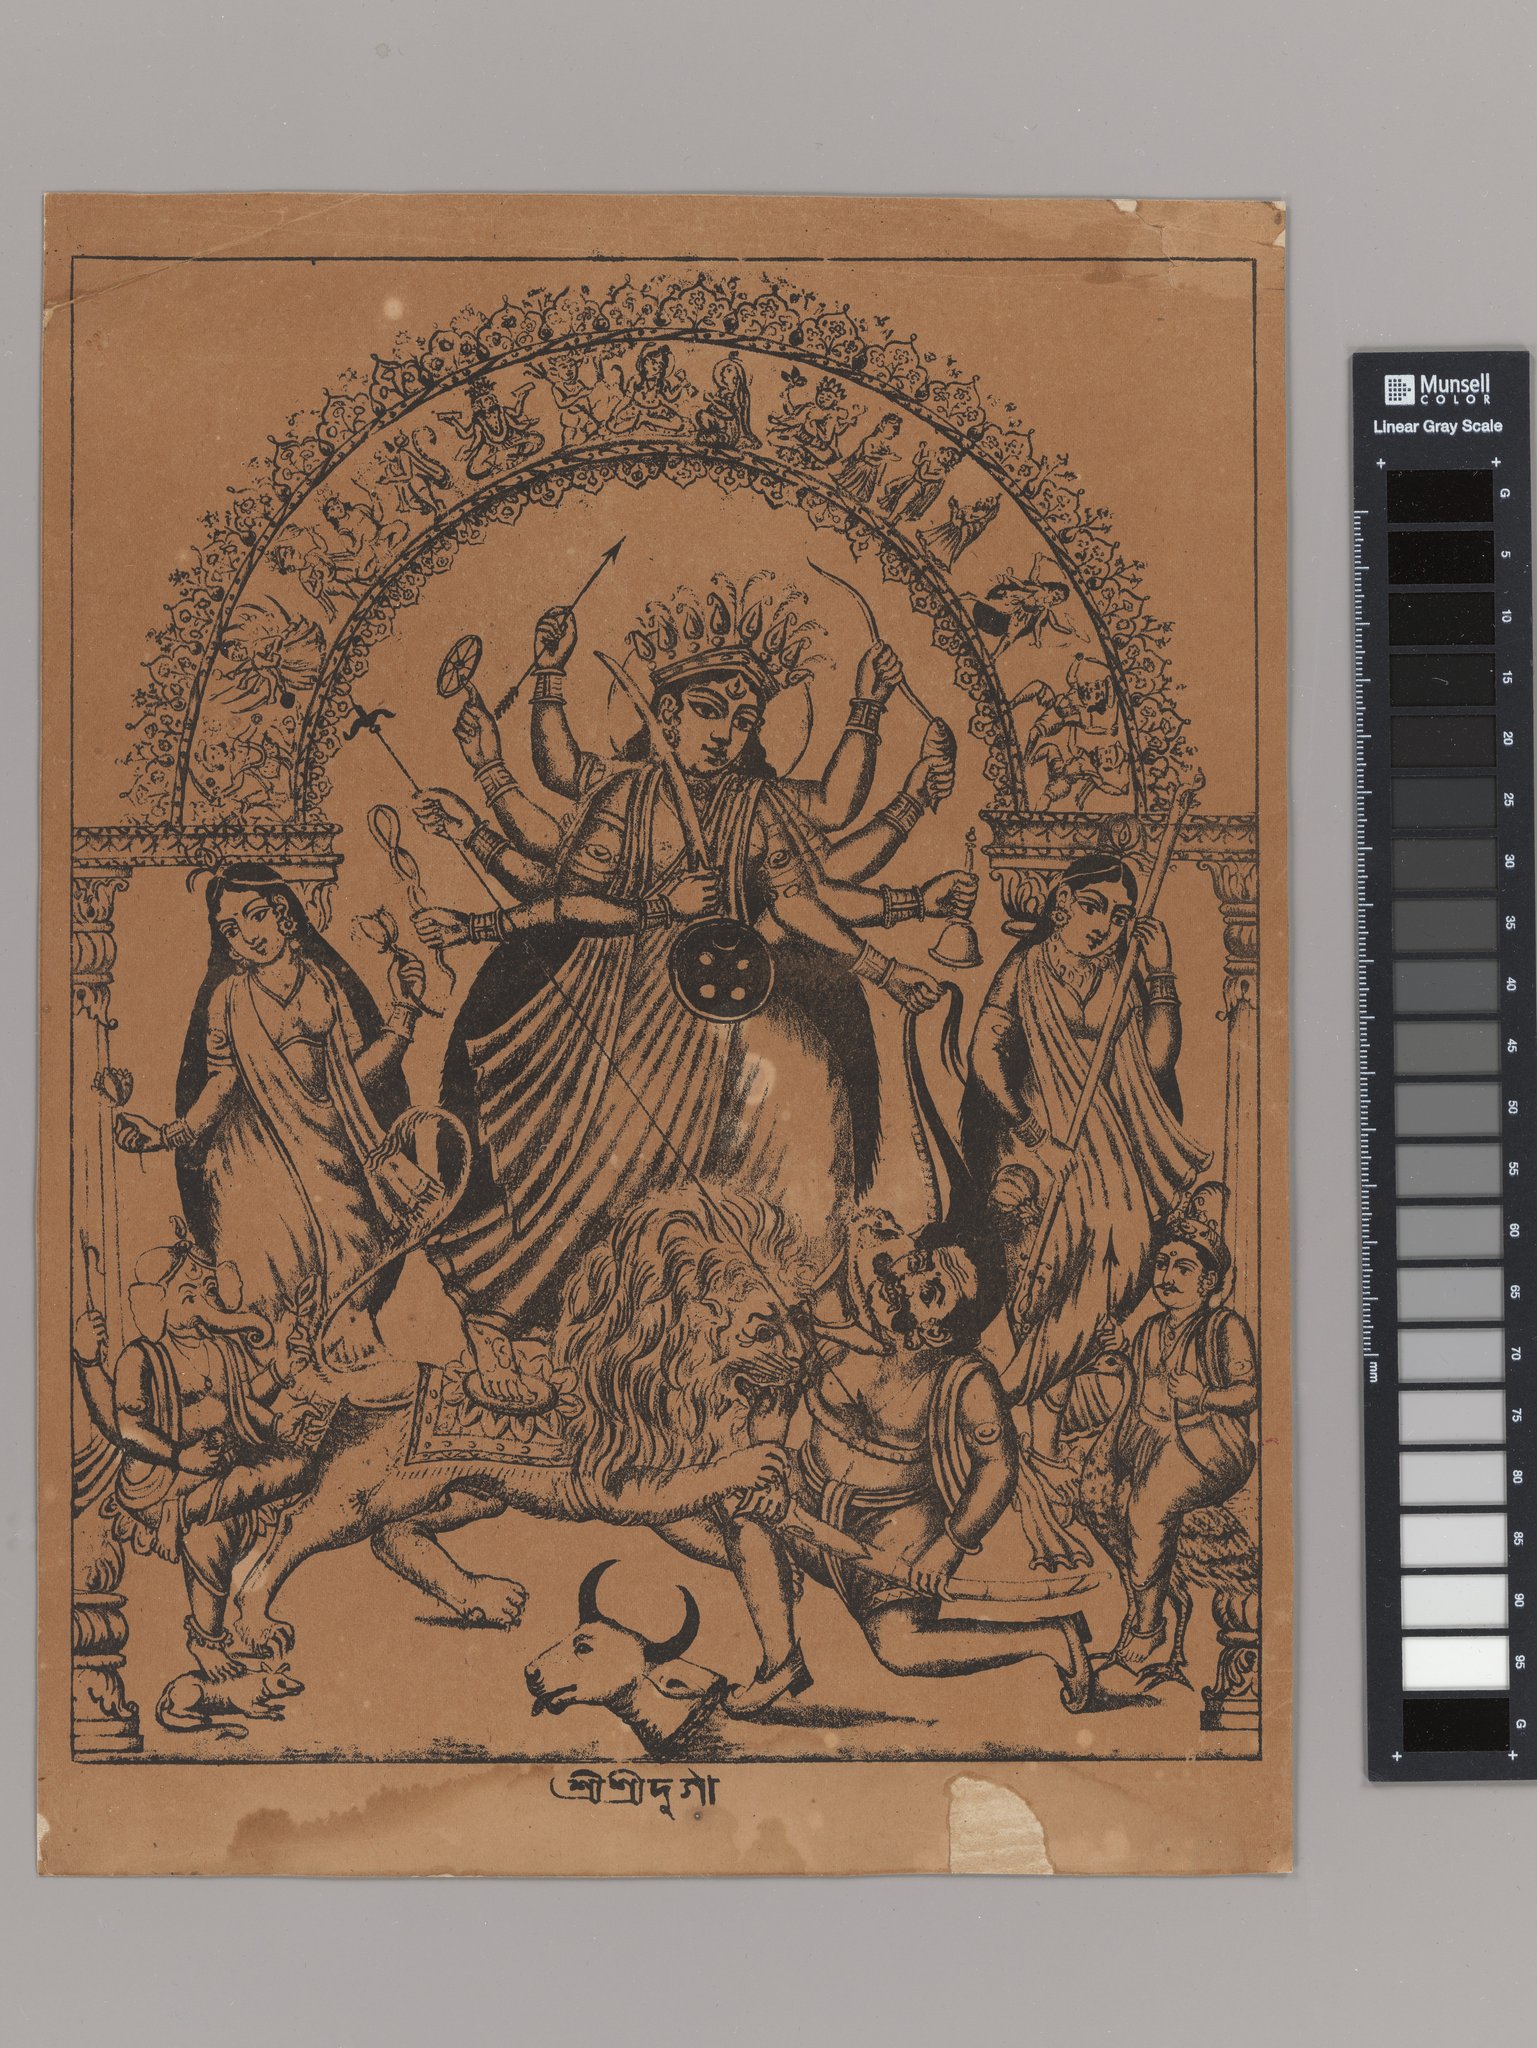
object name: print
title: Sri Sri Durga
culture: indian or west bengali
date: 1875-1880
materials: paper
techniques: lithograph